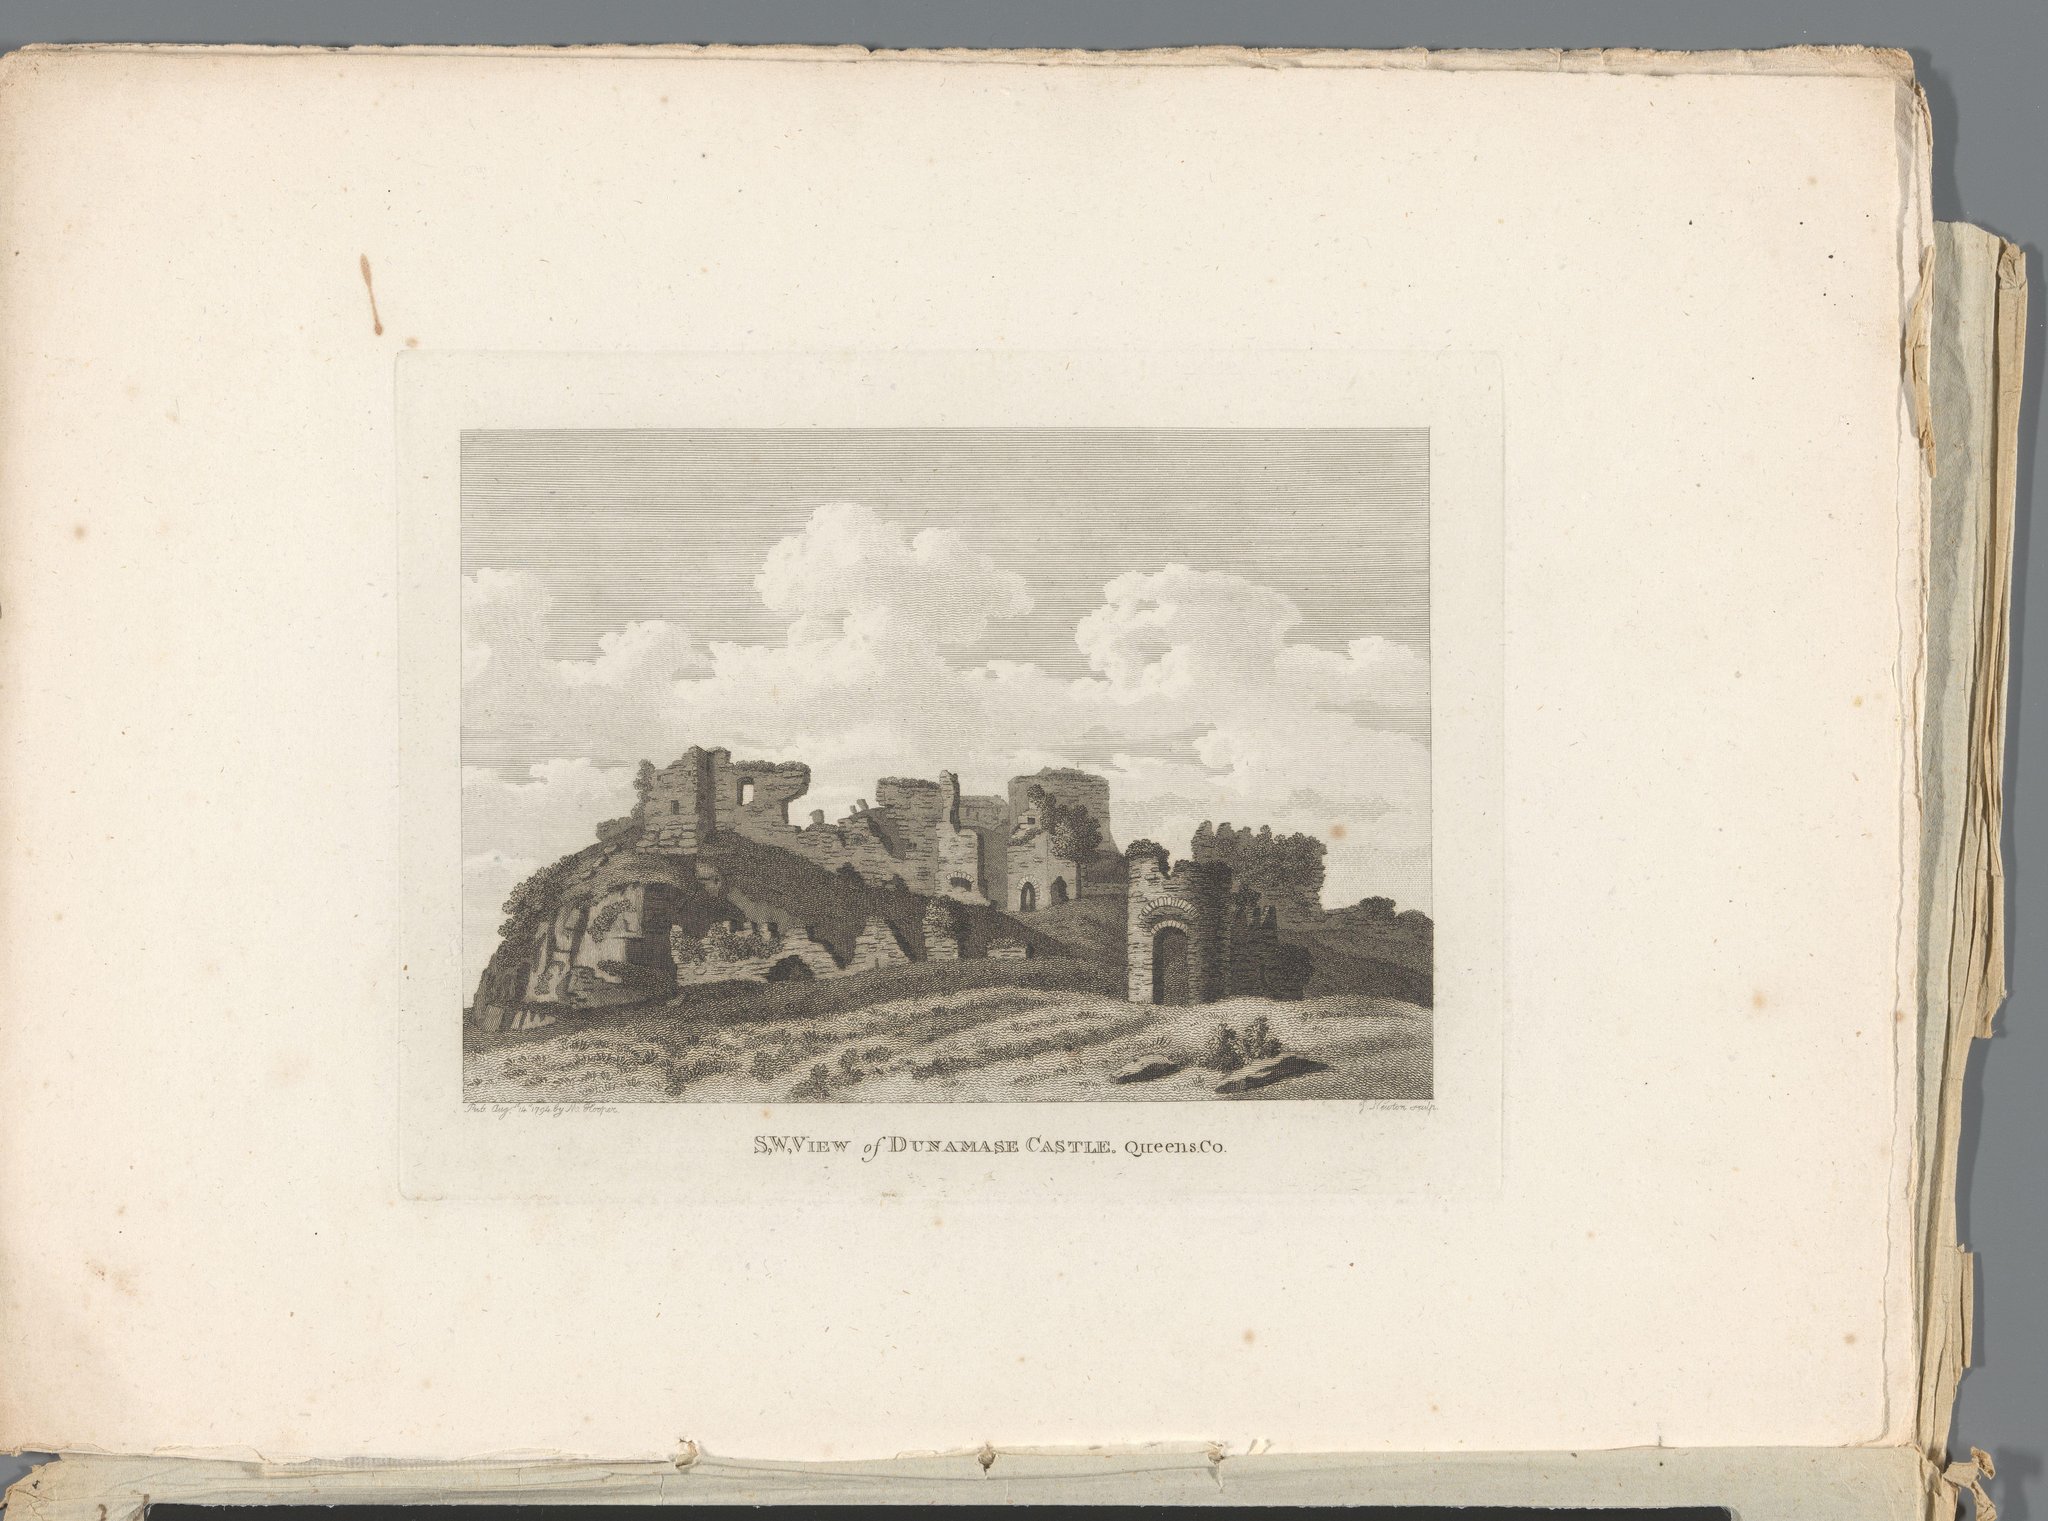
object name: book illustration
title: S.W.View of Dunamase Castle. Queens.Co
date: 1794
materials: paper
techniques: etching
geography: london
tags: landscape with ruins, landscape with tower or castle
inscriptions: date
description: Prent verschenen in: Grose, Francis. The antiquities of Ireland. Londen: S. Hooper, 1795, dl. 2.